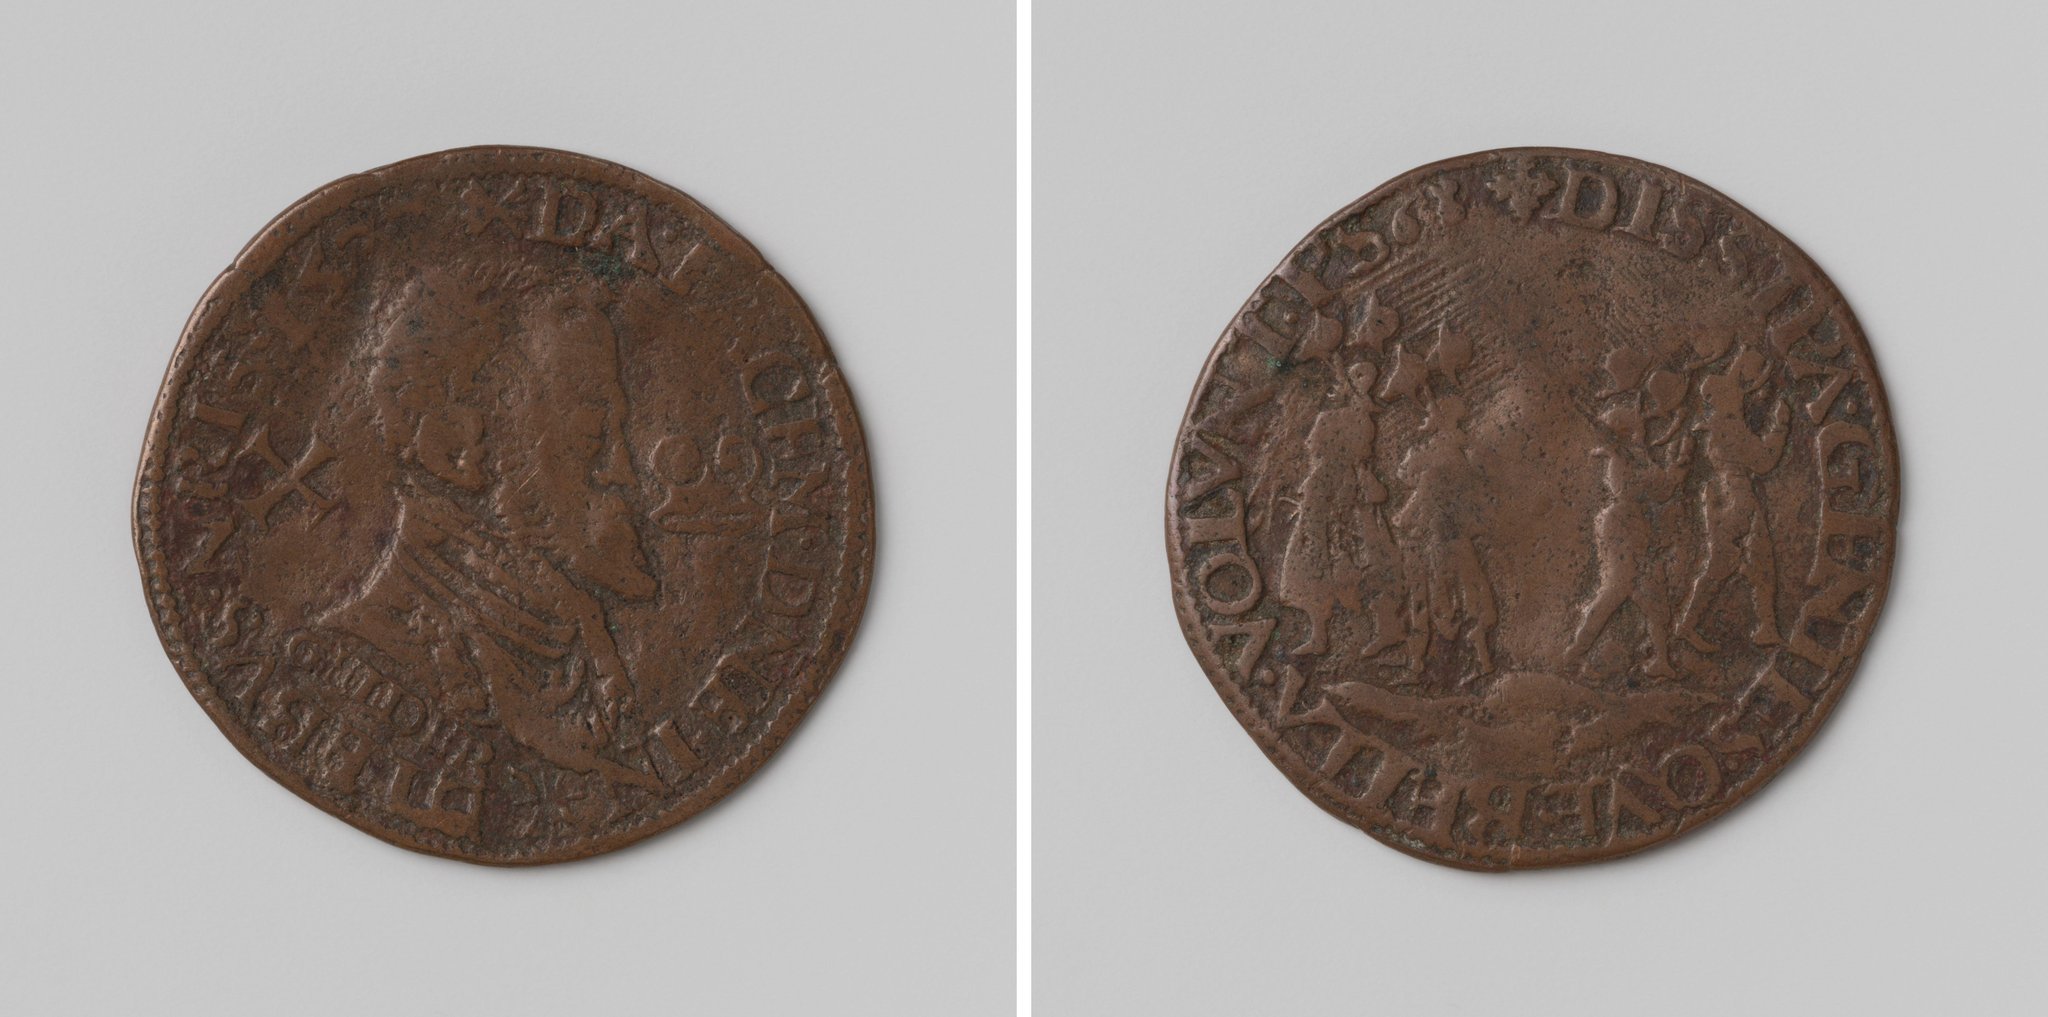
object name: jeton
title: Afbreken van de onderhandelingen met don Juan, ter ere van Filips II, koning van Spanje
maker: Anonymous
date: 1577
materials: copper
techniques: striking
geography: arnhem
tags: philip ii of spain, don juan van oostenrijk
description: Koperen penning. Voorzijde: borststuk man boven opschrift tussen kruis en vuurslag, waar vonk uitschiet binnen omschrift. Keerzijde: Spaanse en Nederlandse soldaten die elkaar rug toekeren binnen omschrift